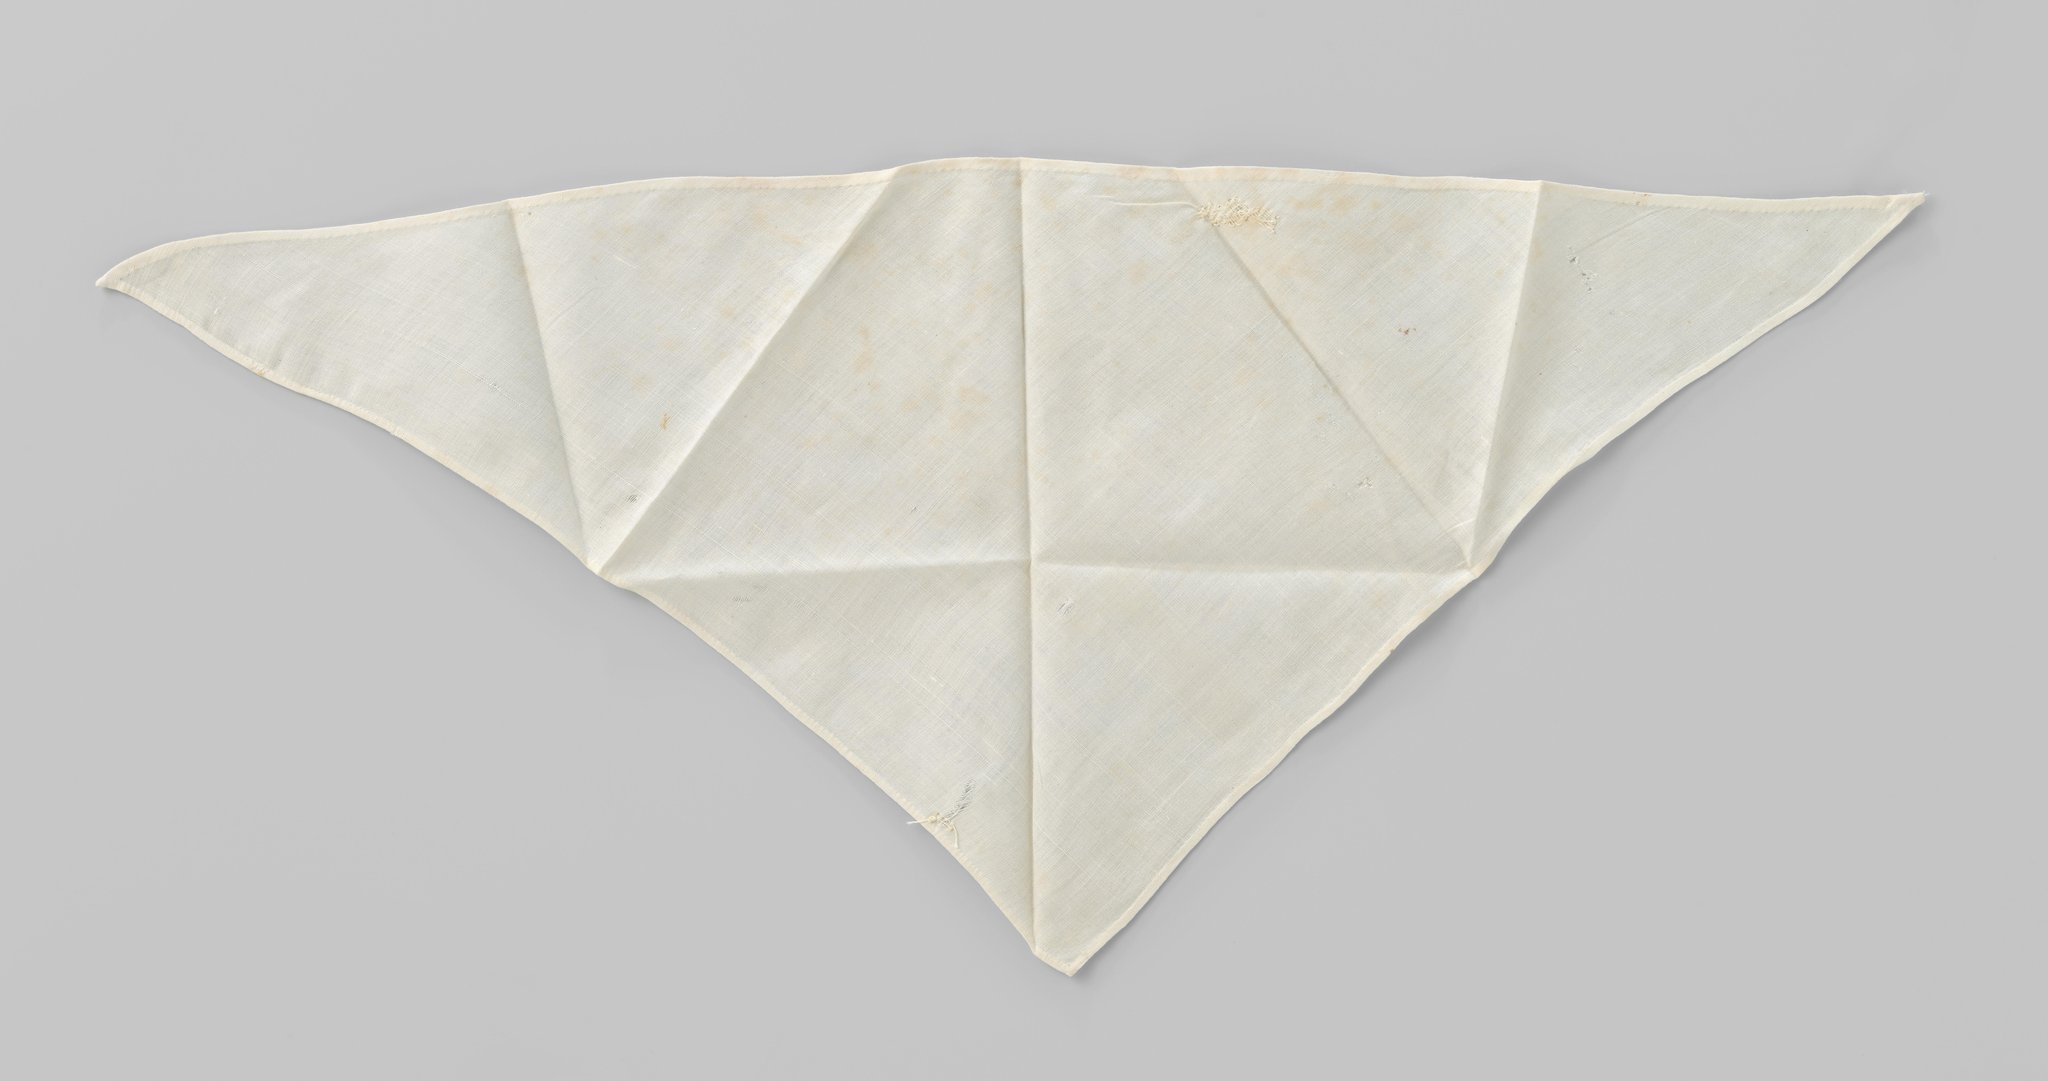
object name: toy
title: Fichu van wit linnen voor pop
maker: Anonymous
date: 1850-1920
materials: linen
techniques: weave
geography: netherlands